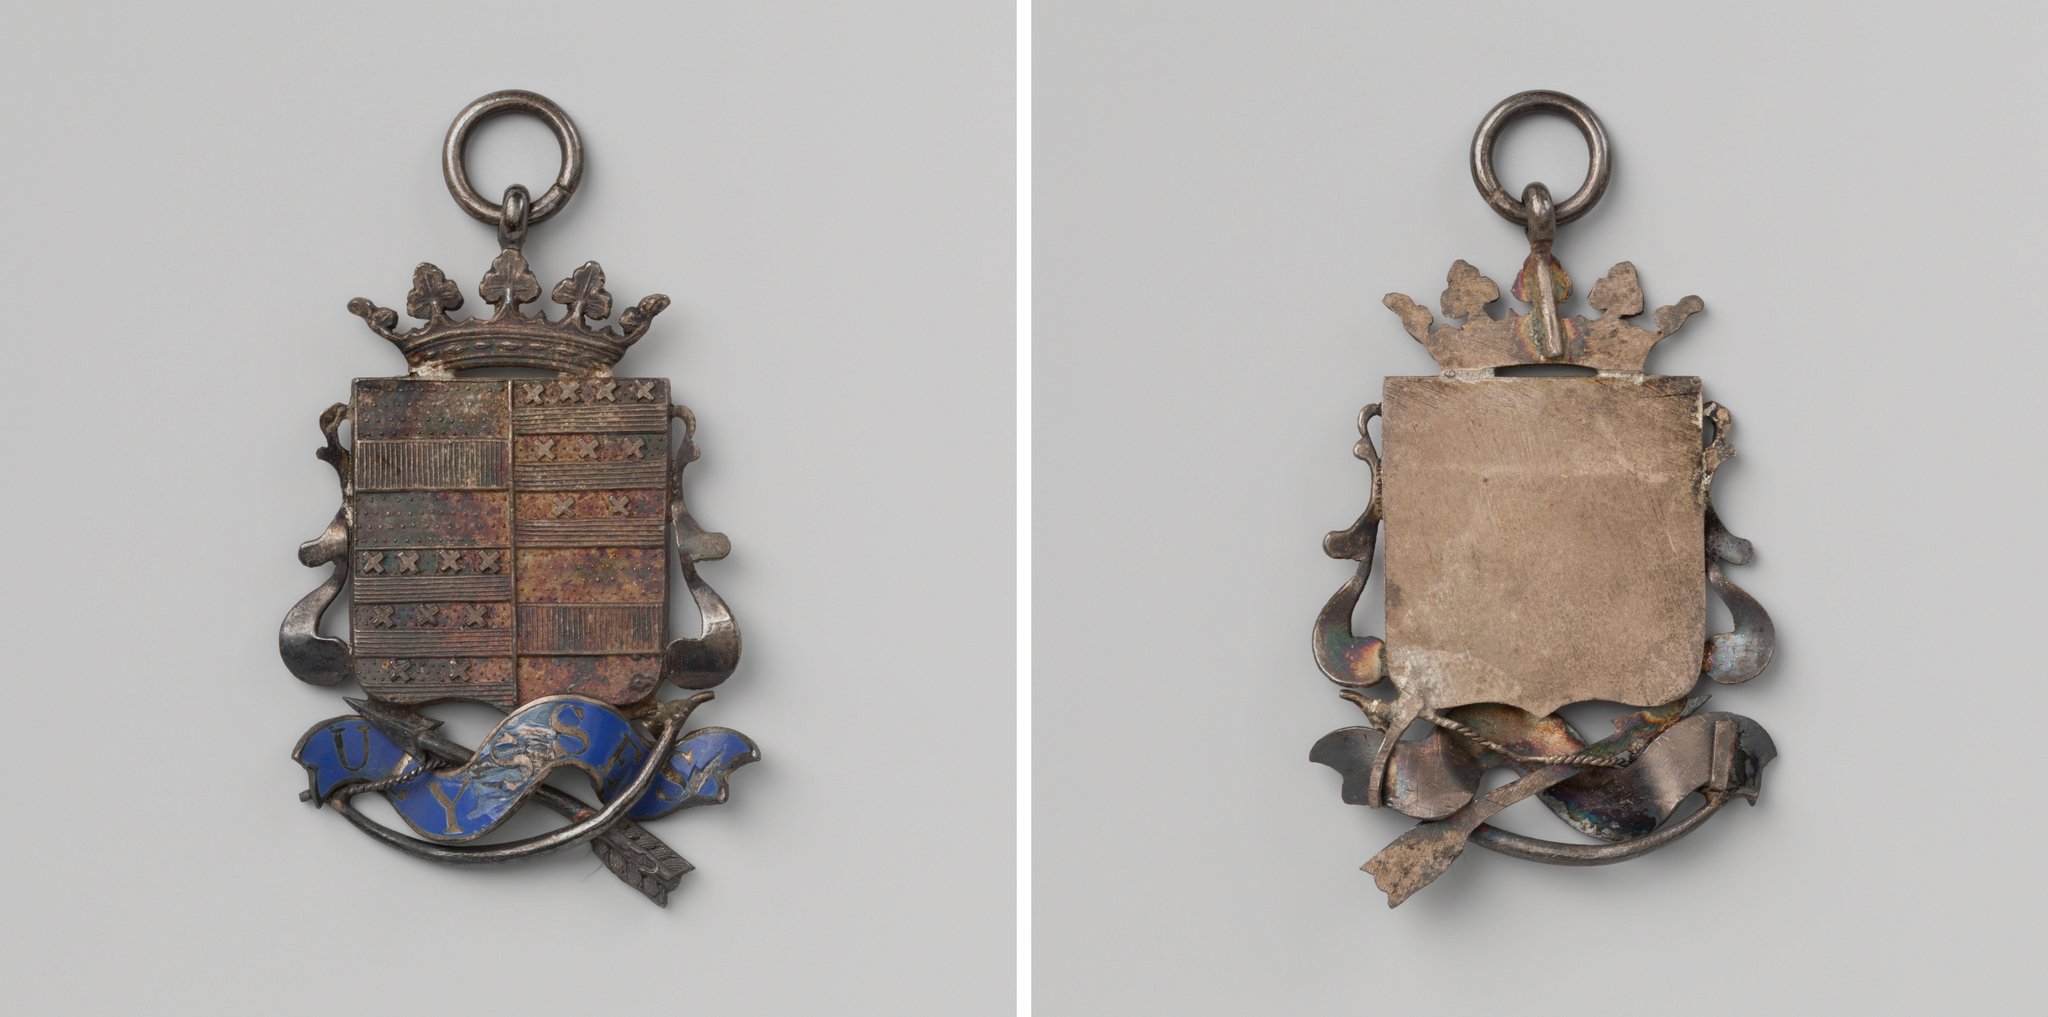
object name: insignia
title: Schuttersvereniging 'Ulysses'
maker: Anonymous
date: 1825-1875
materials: silver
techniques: engraving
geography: netherlands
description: Eenzijdig zilveren draagteken aan draagoog en ring, opgebouwd uit gekroond wapenschild met aan elk van beide zijden guirlande, rustend op gekruiste boog en pijl, omwonden met lint met opschrift